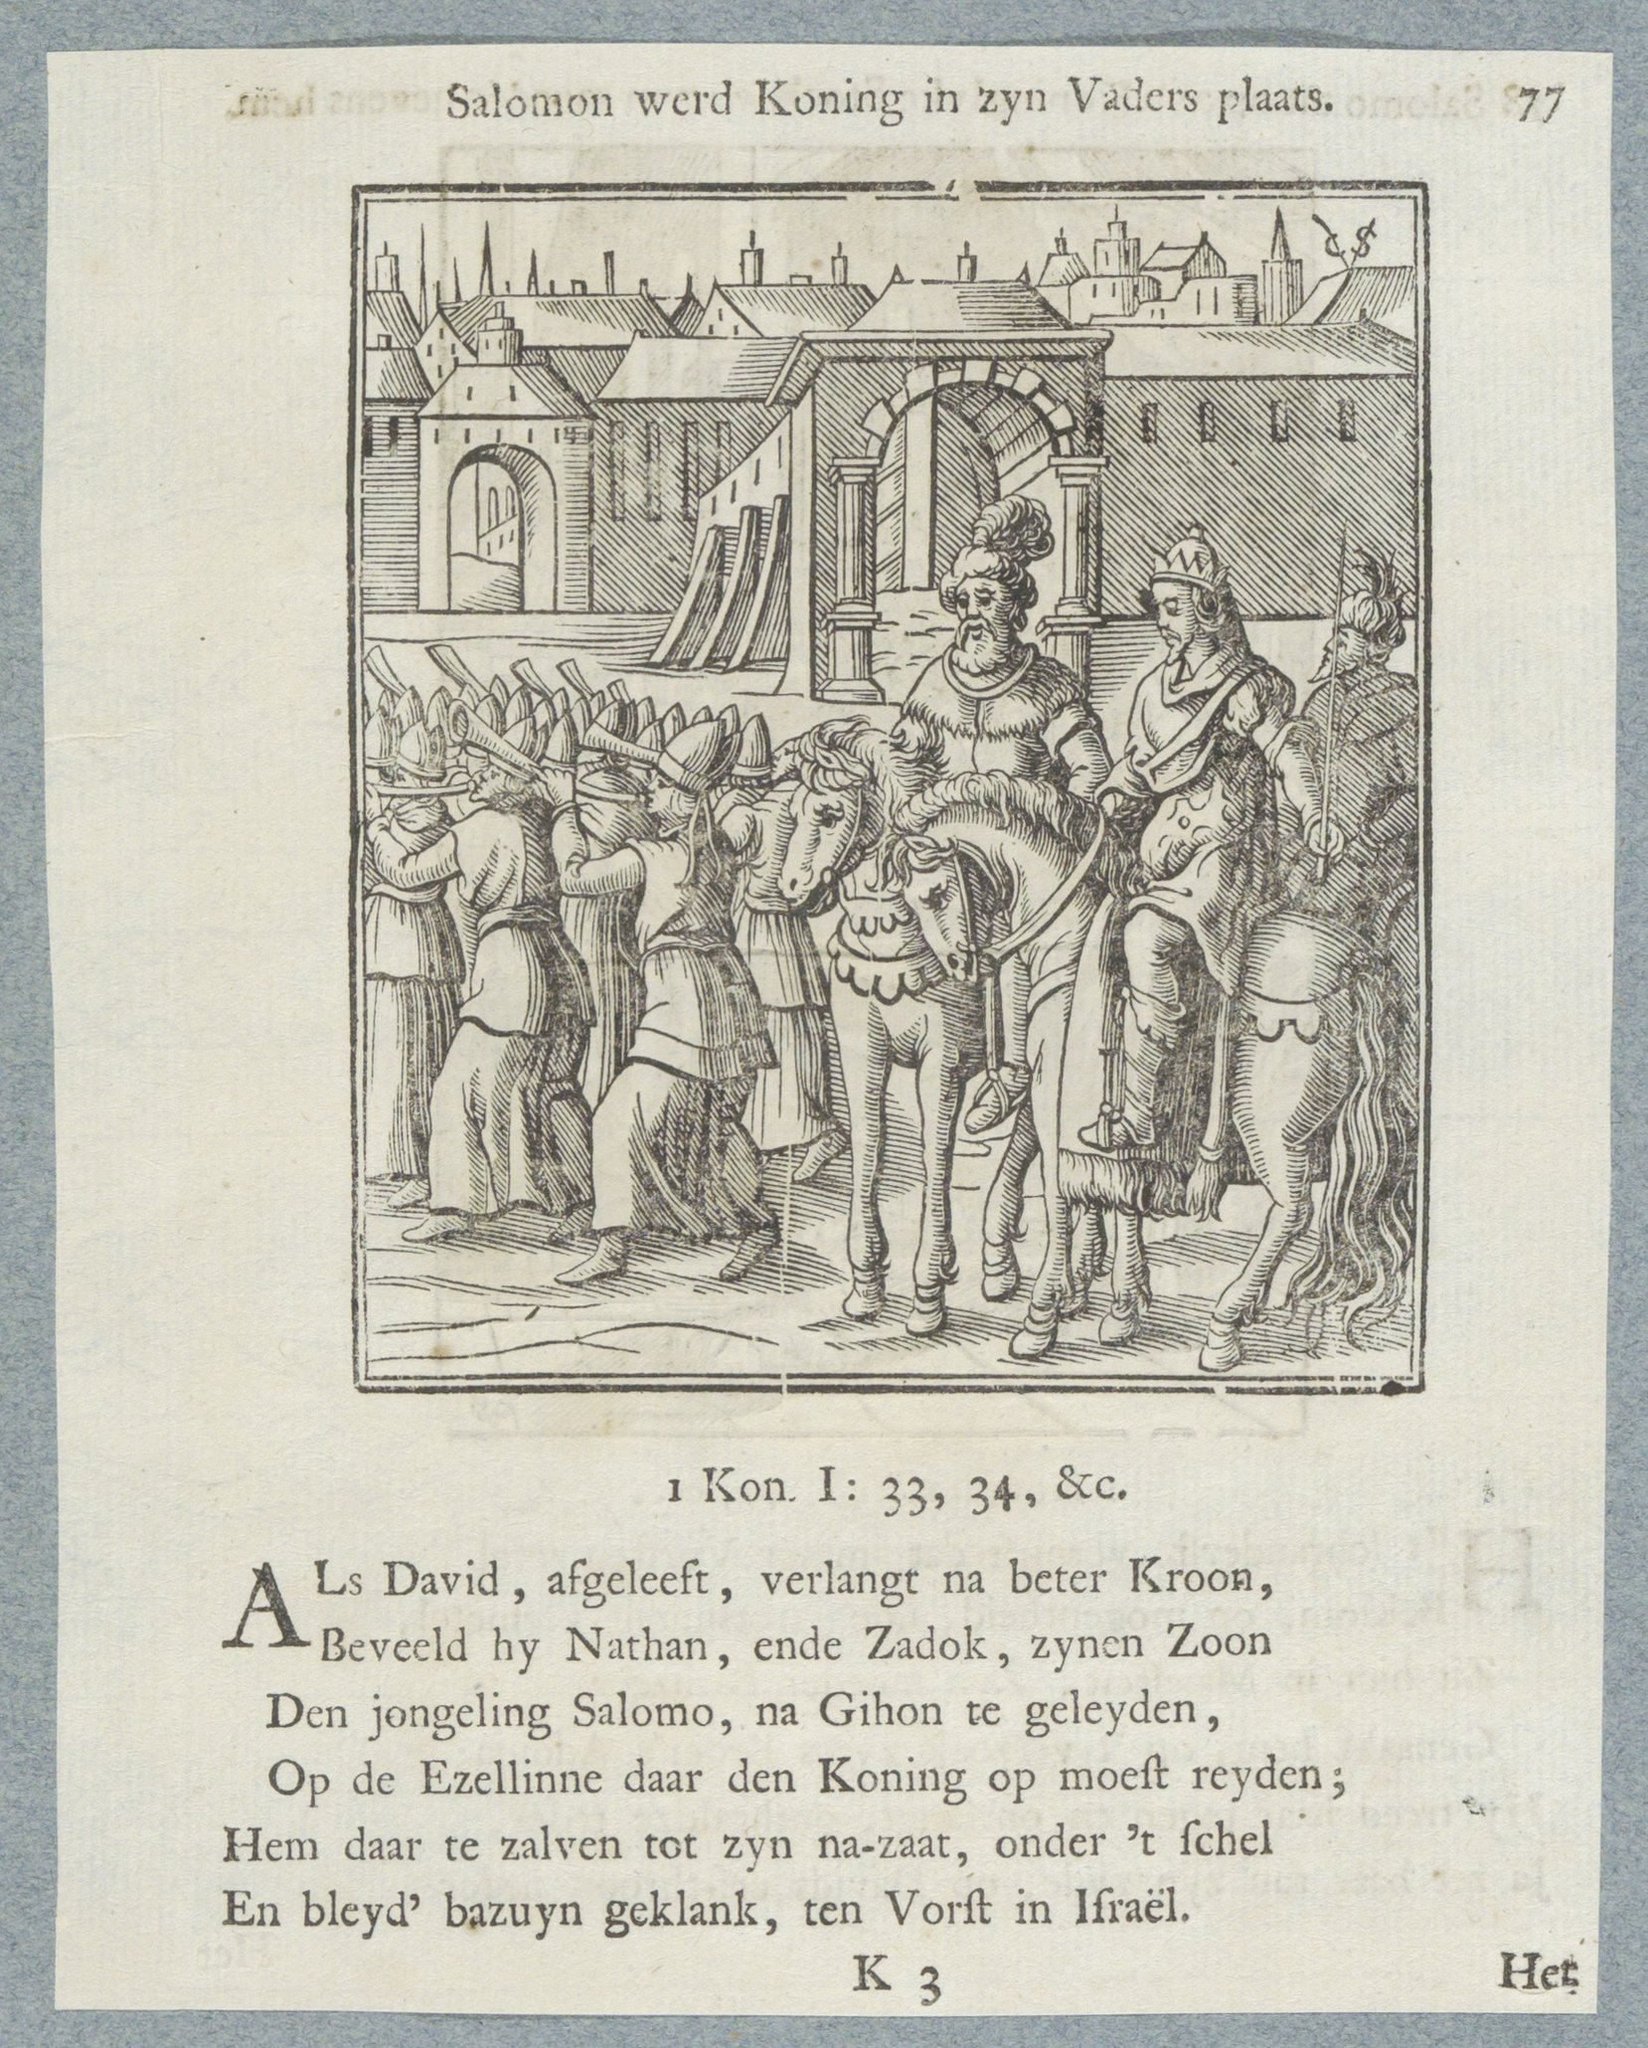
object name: album leaf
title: Salomo's aankomst als koning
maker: jan klooster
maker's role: bookseller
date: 1645-1646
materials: paper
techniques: letterpress printing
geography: amsterdam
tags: solomon's entry into jerusalem as king: he rides on david's mule and all the people rejoice and blow their trumpets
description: De prent is afkomstig uit: Bybels Lusthof. Amsterdam, J. Klooster, 1740. De prent werd gemaakt voor de uitgaven van P.J. Paets uit Amsterdam. Ze komt in ieder geval voor in: Bibels Tresoor ofte der zielen lusthof. Amsterdam, P.J. Paets, 1646. Mogelijk staat ze ook in: Historien ende Prophetien. [Amsterdam], P.J. Paets, 1645.